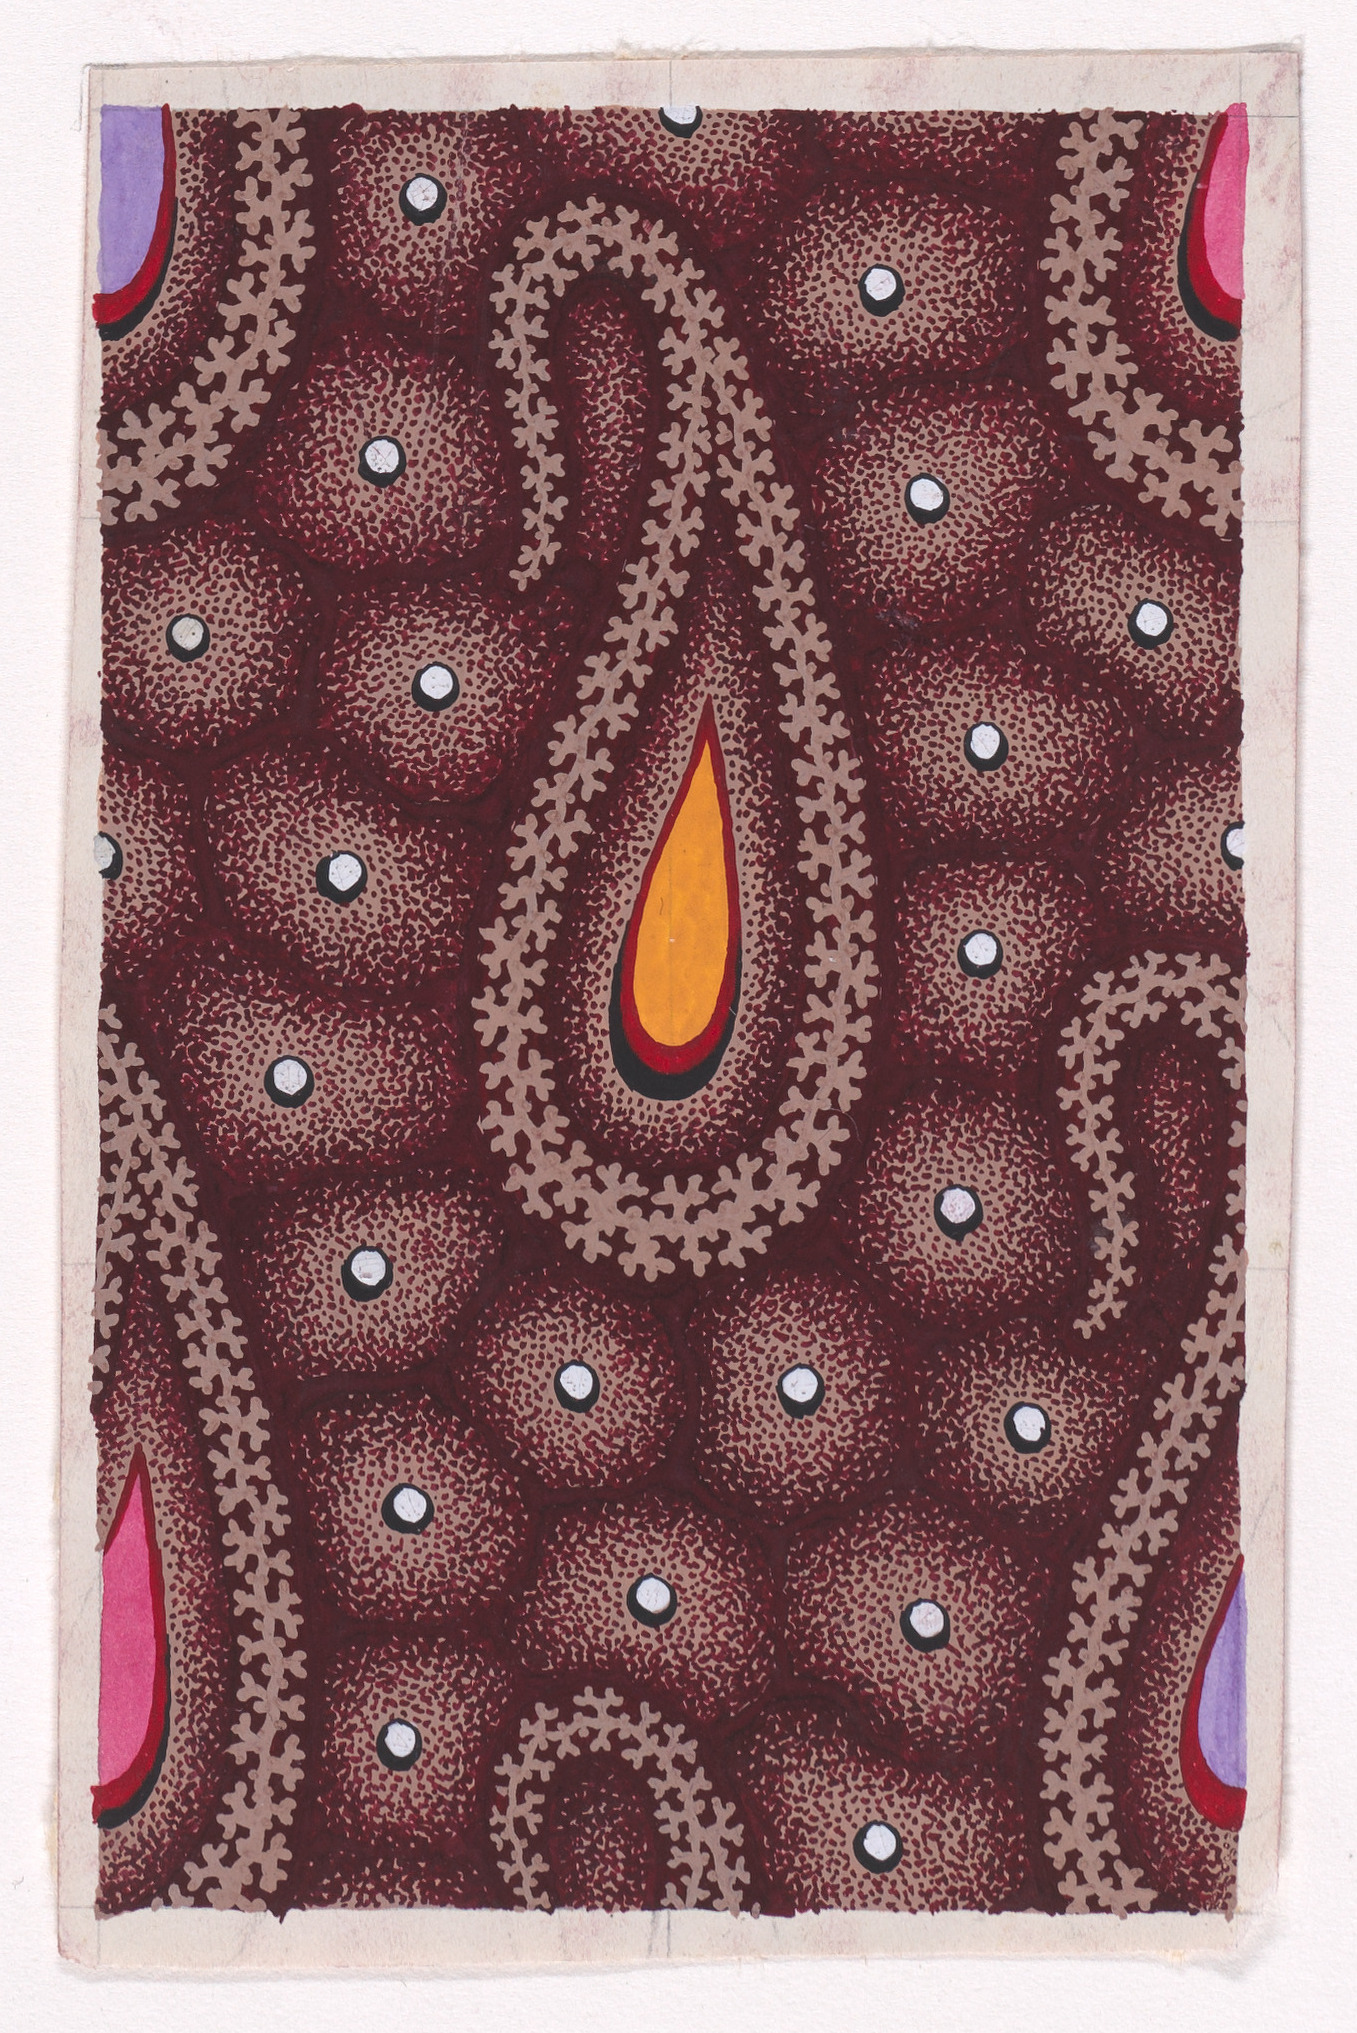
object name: drawing ornament architecture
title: Textile Design with Alternating Rows of Paisley Motifs Outlined with Branches and Decorated with a Teardrop Shape over an Abstract Honeycomb Pattern Decorated with Pearls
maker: anonymous, alsatian, 19th century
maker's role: artist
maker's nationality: alsatian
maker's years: 1800-1900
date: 1840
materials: gouache